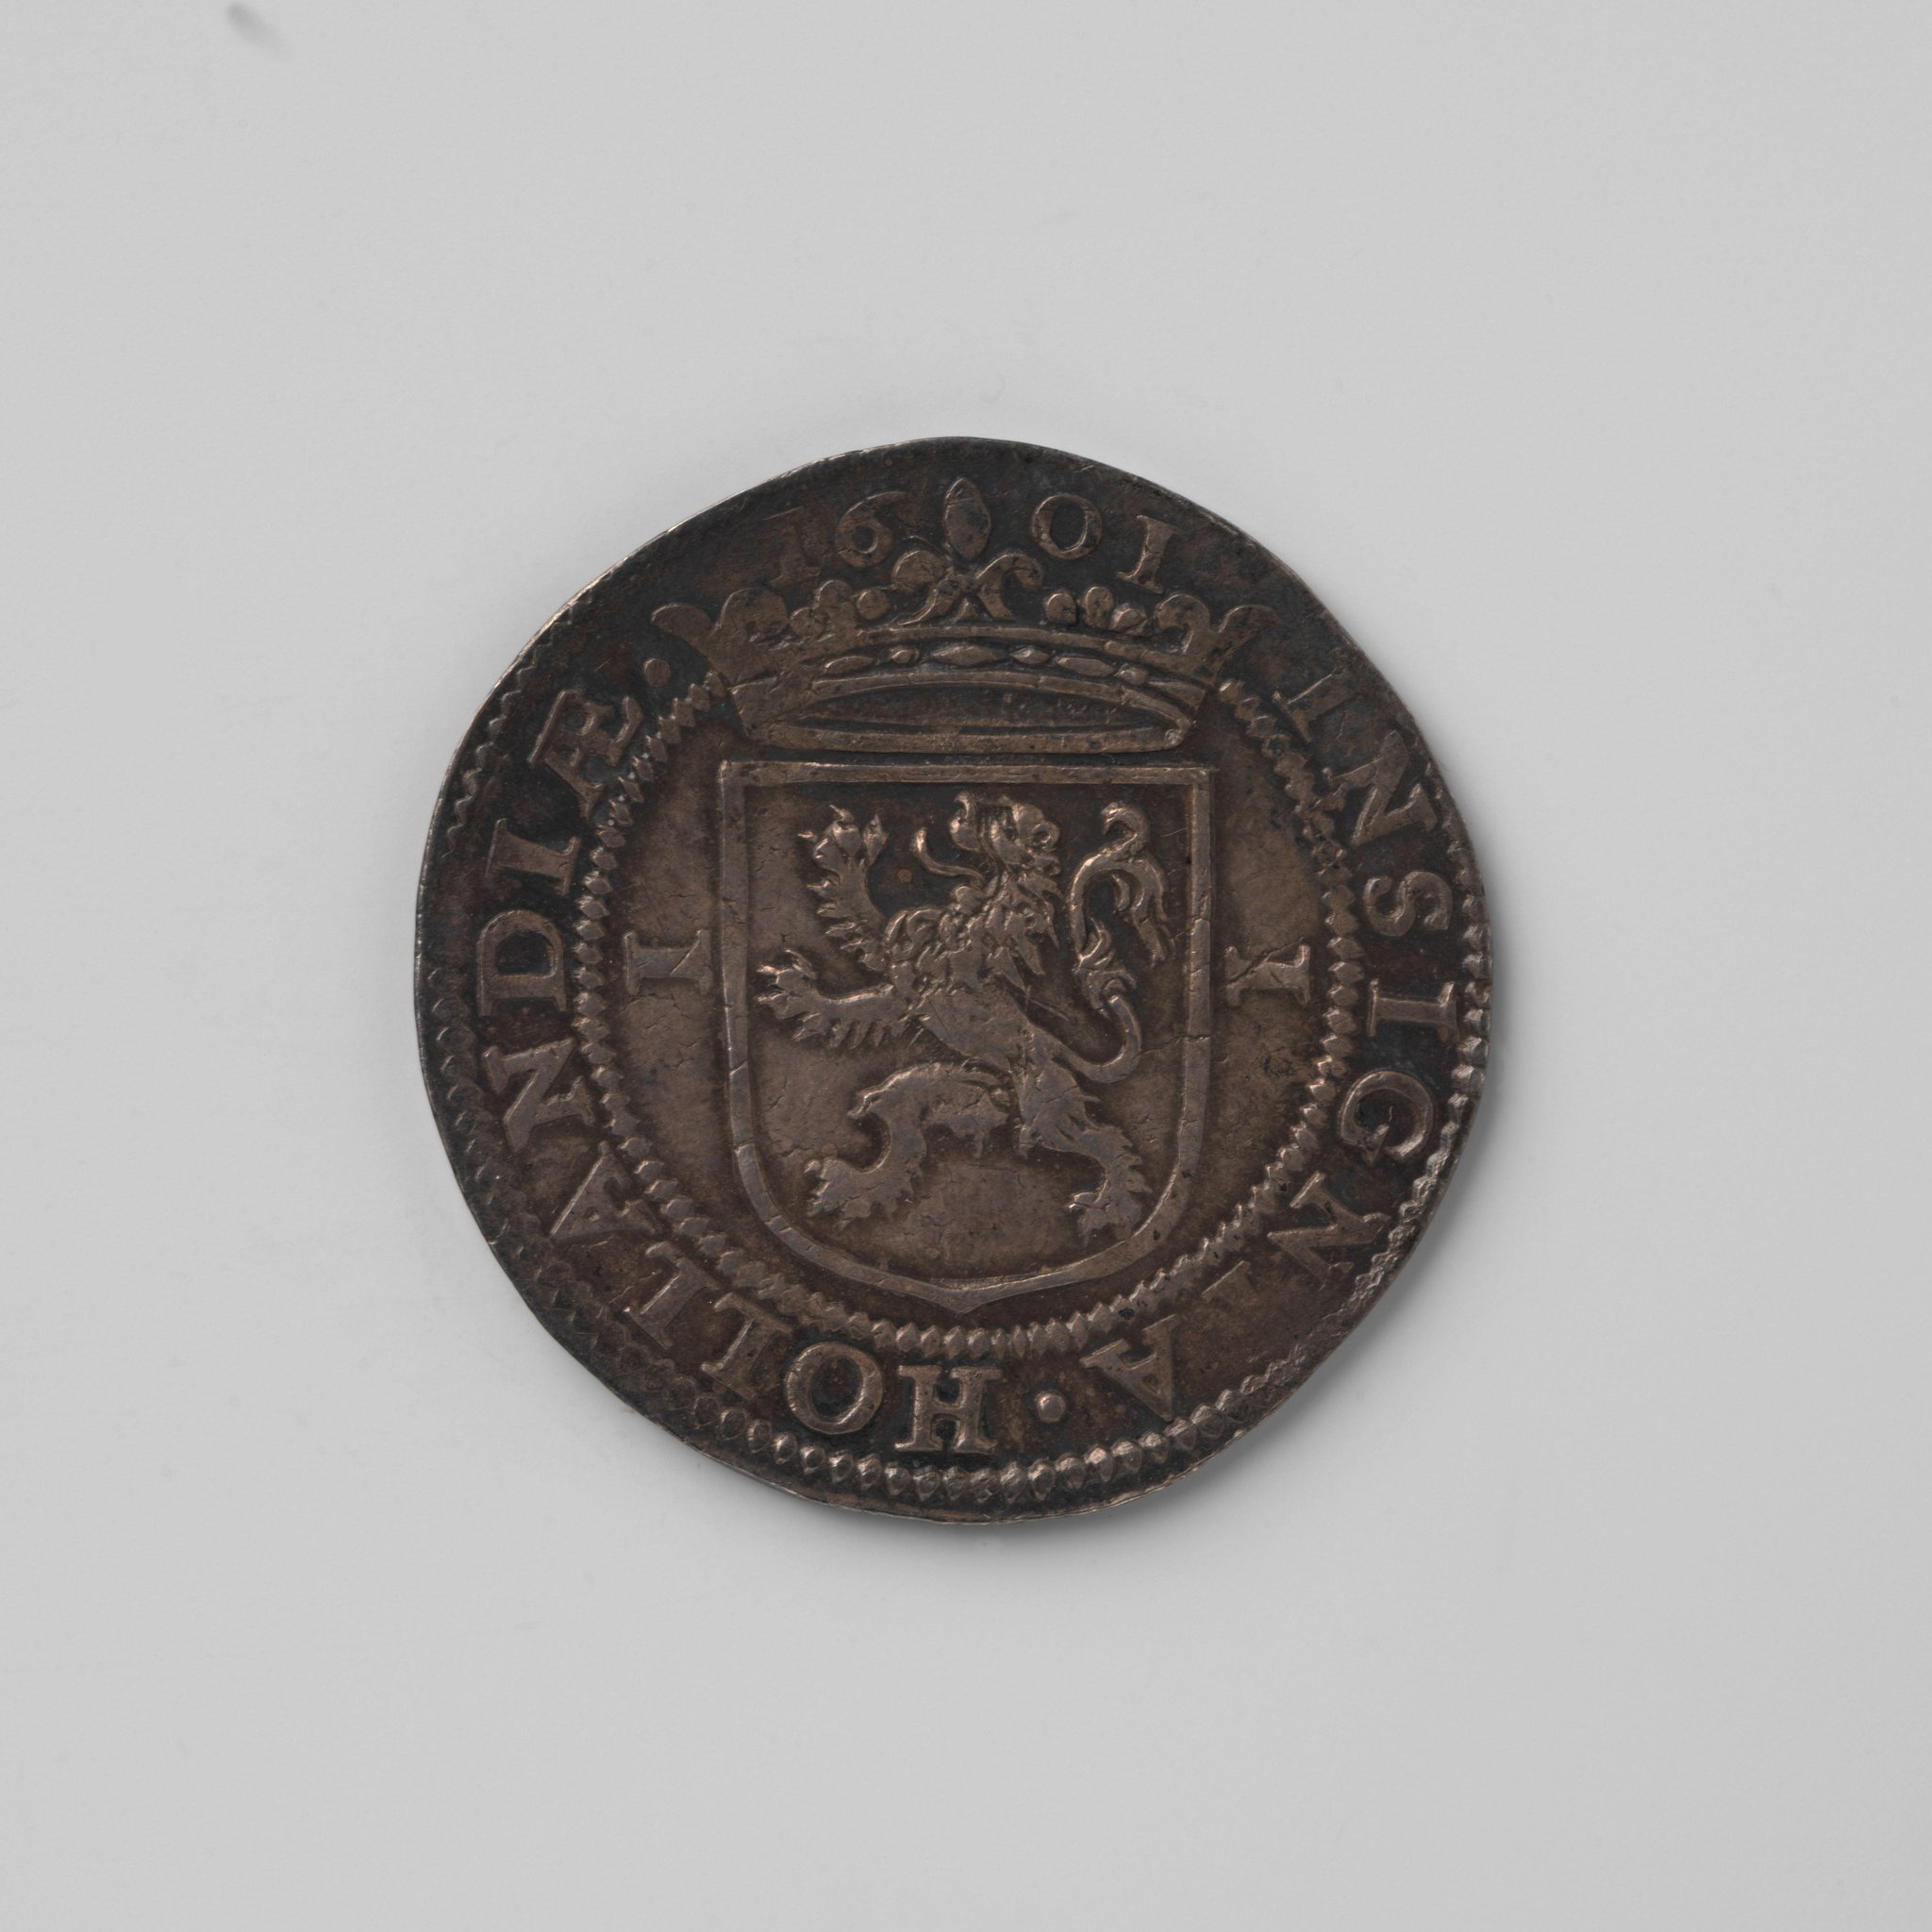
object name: kwart daalder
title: kwart daalder; dubbele reaal van achten van de Verenigde Amsterdamse Compagnie, 1601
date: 1601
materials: silver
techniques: striking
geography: dordrecht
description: Zilveren munt. Voorzijde: tussen waarde-aanduiding gekroond wapenschild van Holland, waarboven jaartal. Keerzijde: door twee leeuwen gehouden wapenschild van Amsterdam.